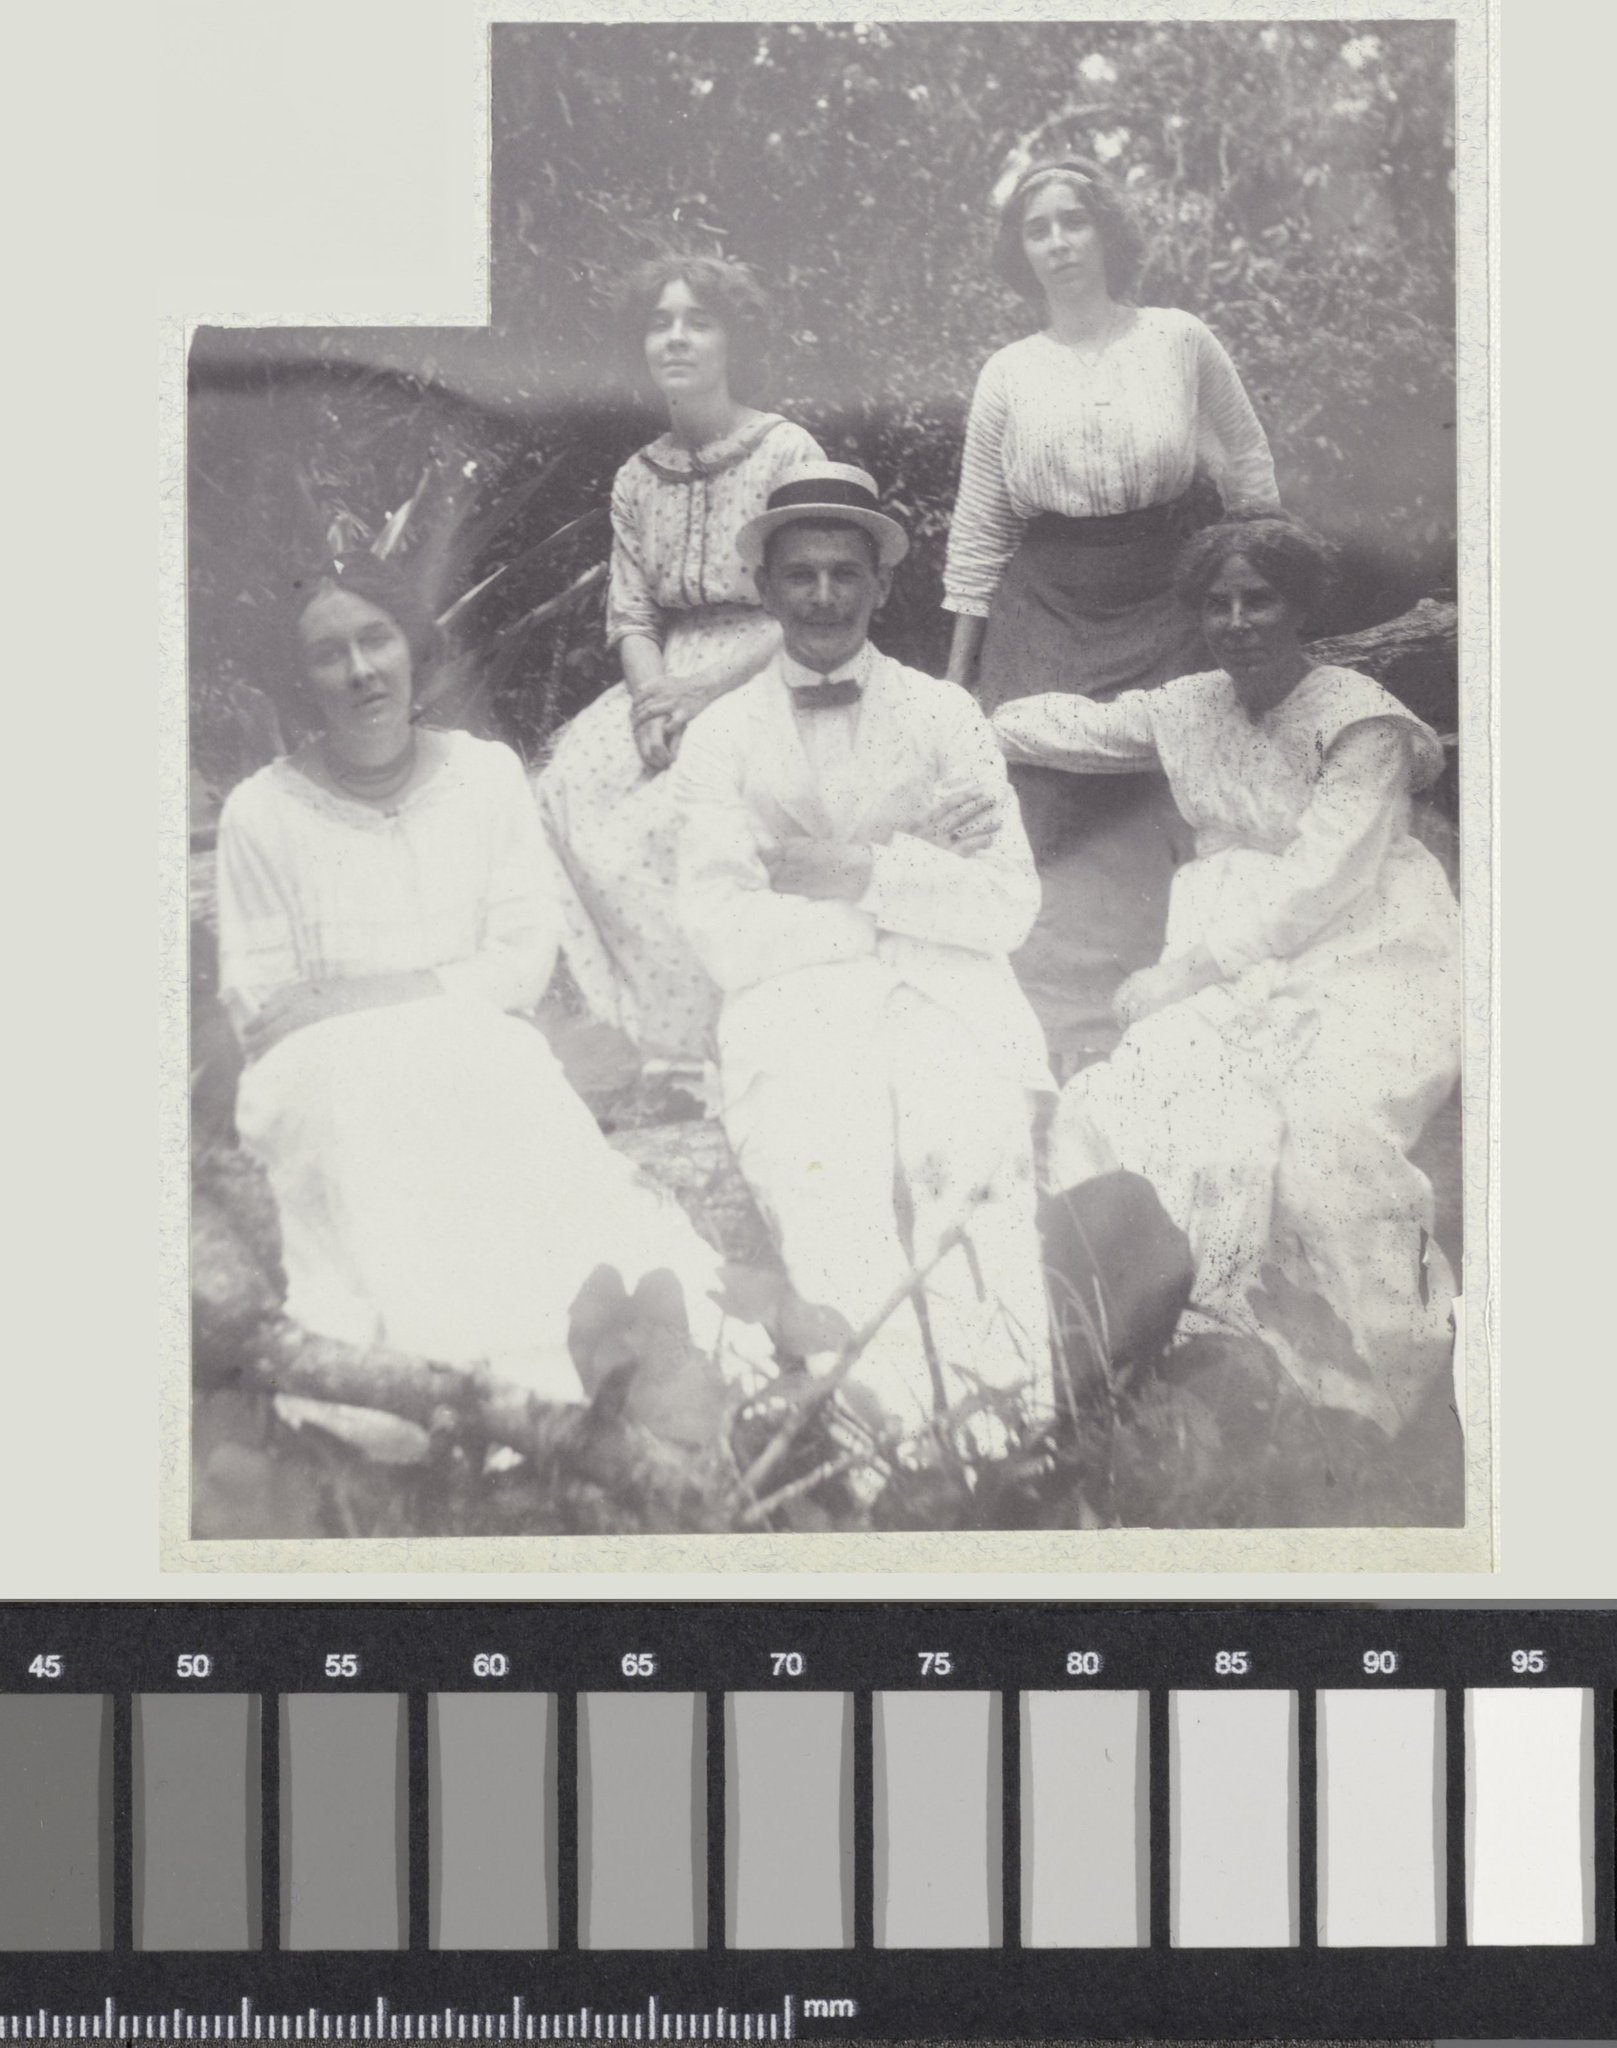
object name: photograph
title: Gezelschap op een plantage, met links Maria Gonggrijp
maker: andries augustus boom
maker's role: amateurfotograaf, handelaar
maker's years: 1878-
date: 1910-1912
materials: photographic support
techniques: photography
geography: suriname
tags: plantation, suriname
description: Gezelschap van vijf personen op een plantage, links Maria Gonggrijp. Onderdeel van het fotoalbum van de familie Boom-Gonggrijp in Suriname en Curaçao.